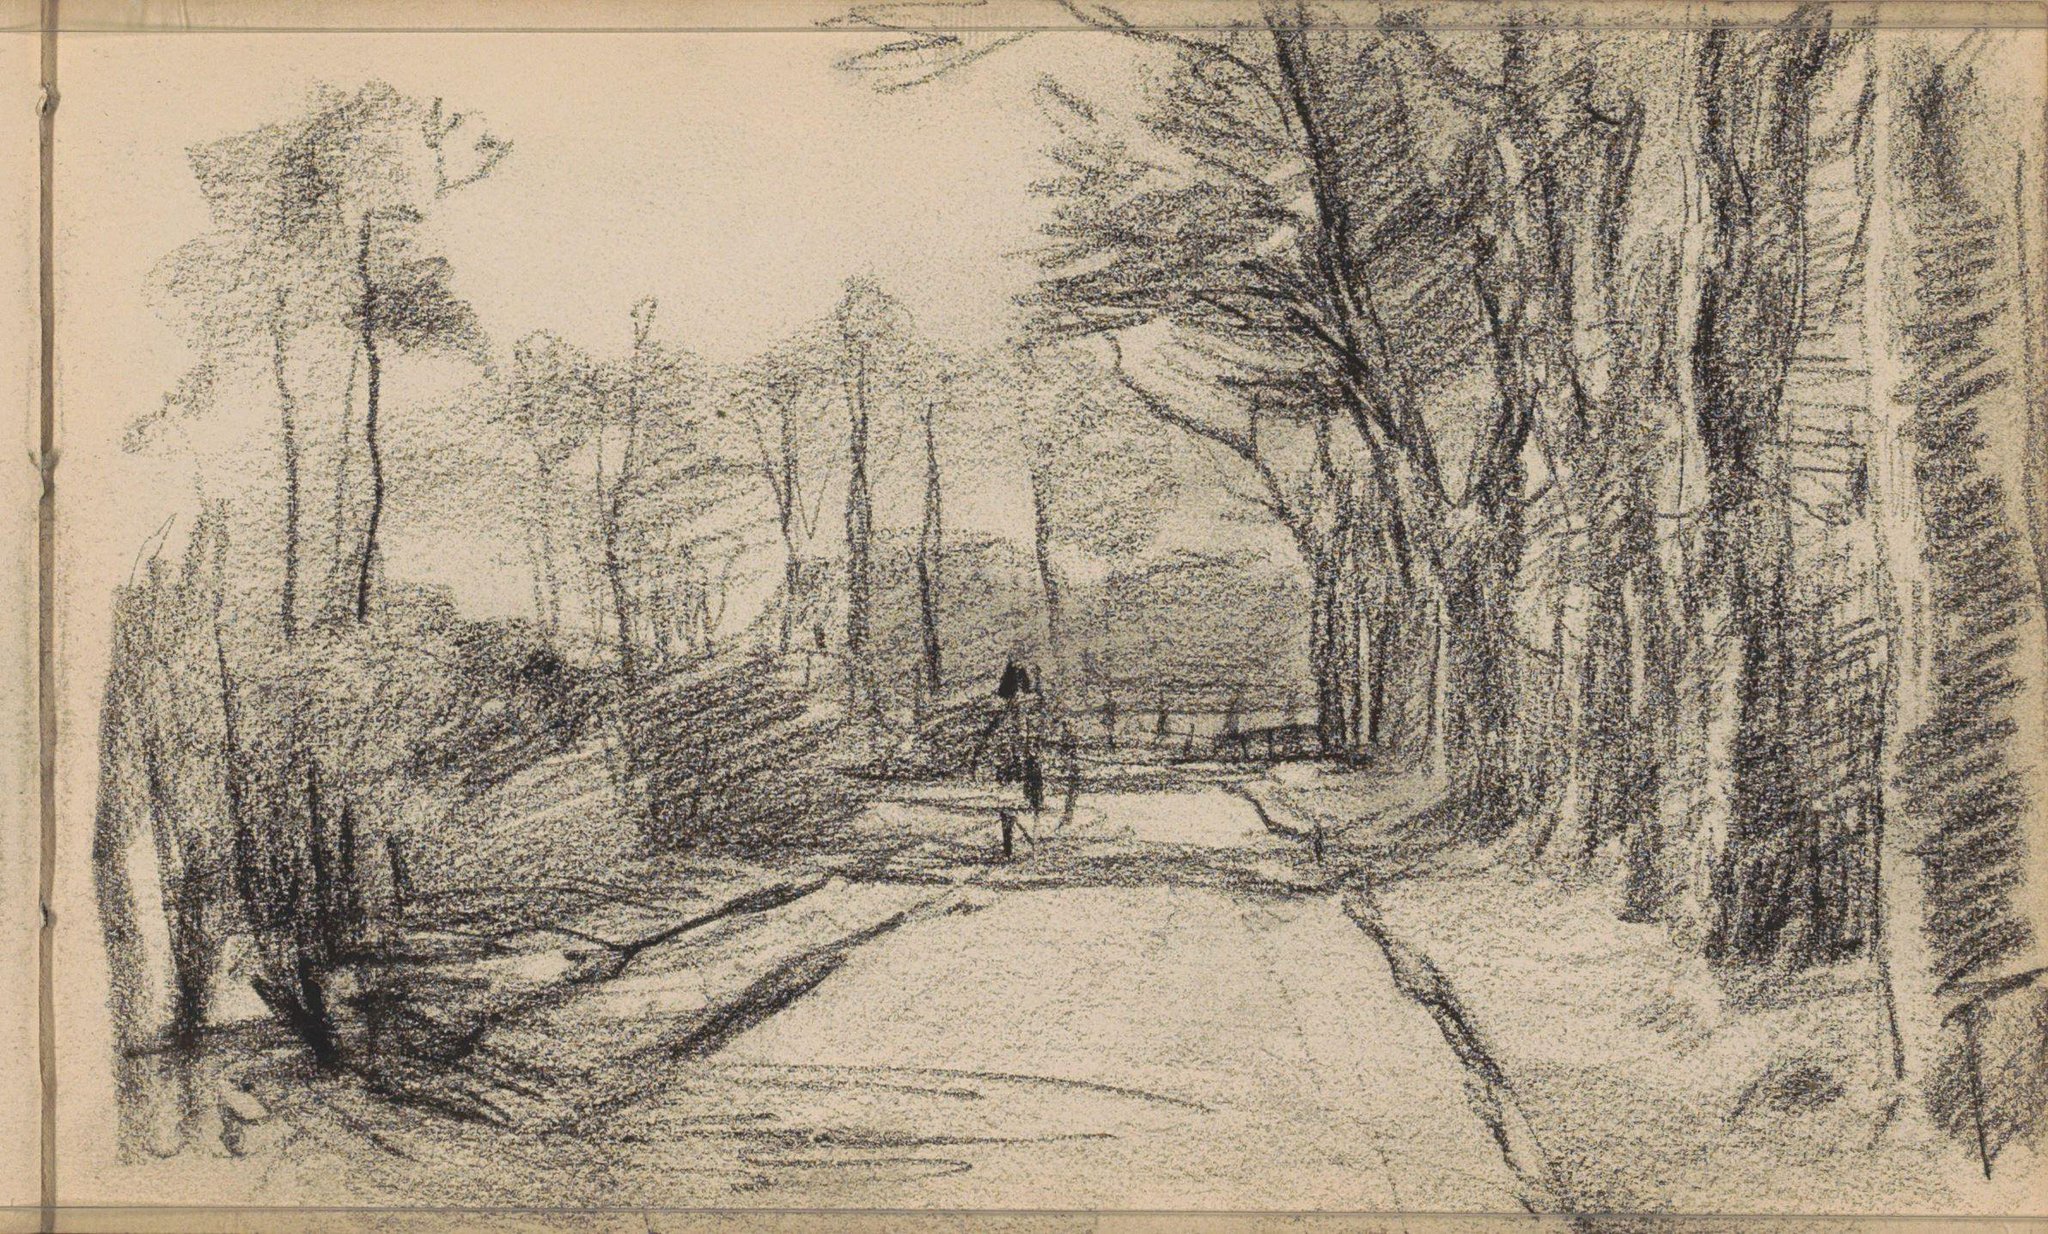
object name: sketchbook leaf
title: Gezicht op een pad langs bomen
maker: johan antonie de jonge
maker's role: draughtsman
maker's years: 1864-1927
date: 1901-1927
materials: chalk, paper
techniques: stumping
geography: south holland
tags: trees, road, path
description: Gezicht op een pad langs bomen. Blad 26 uit een schetsboek met 45 bladen.